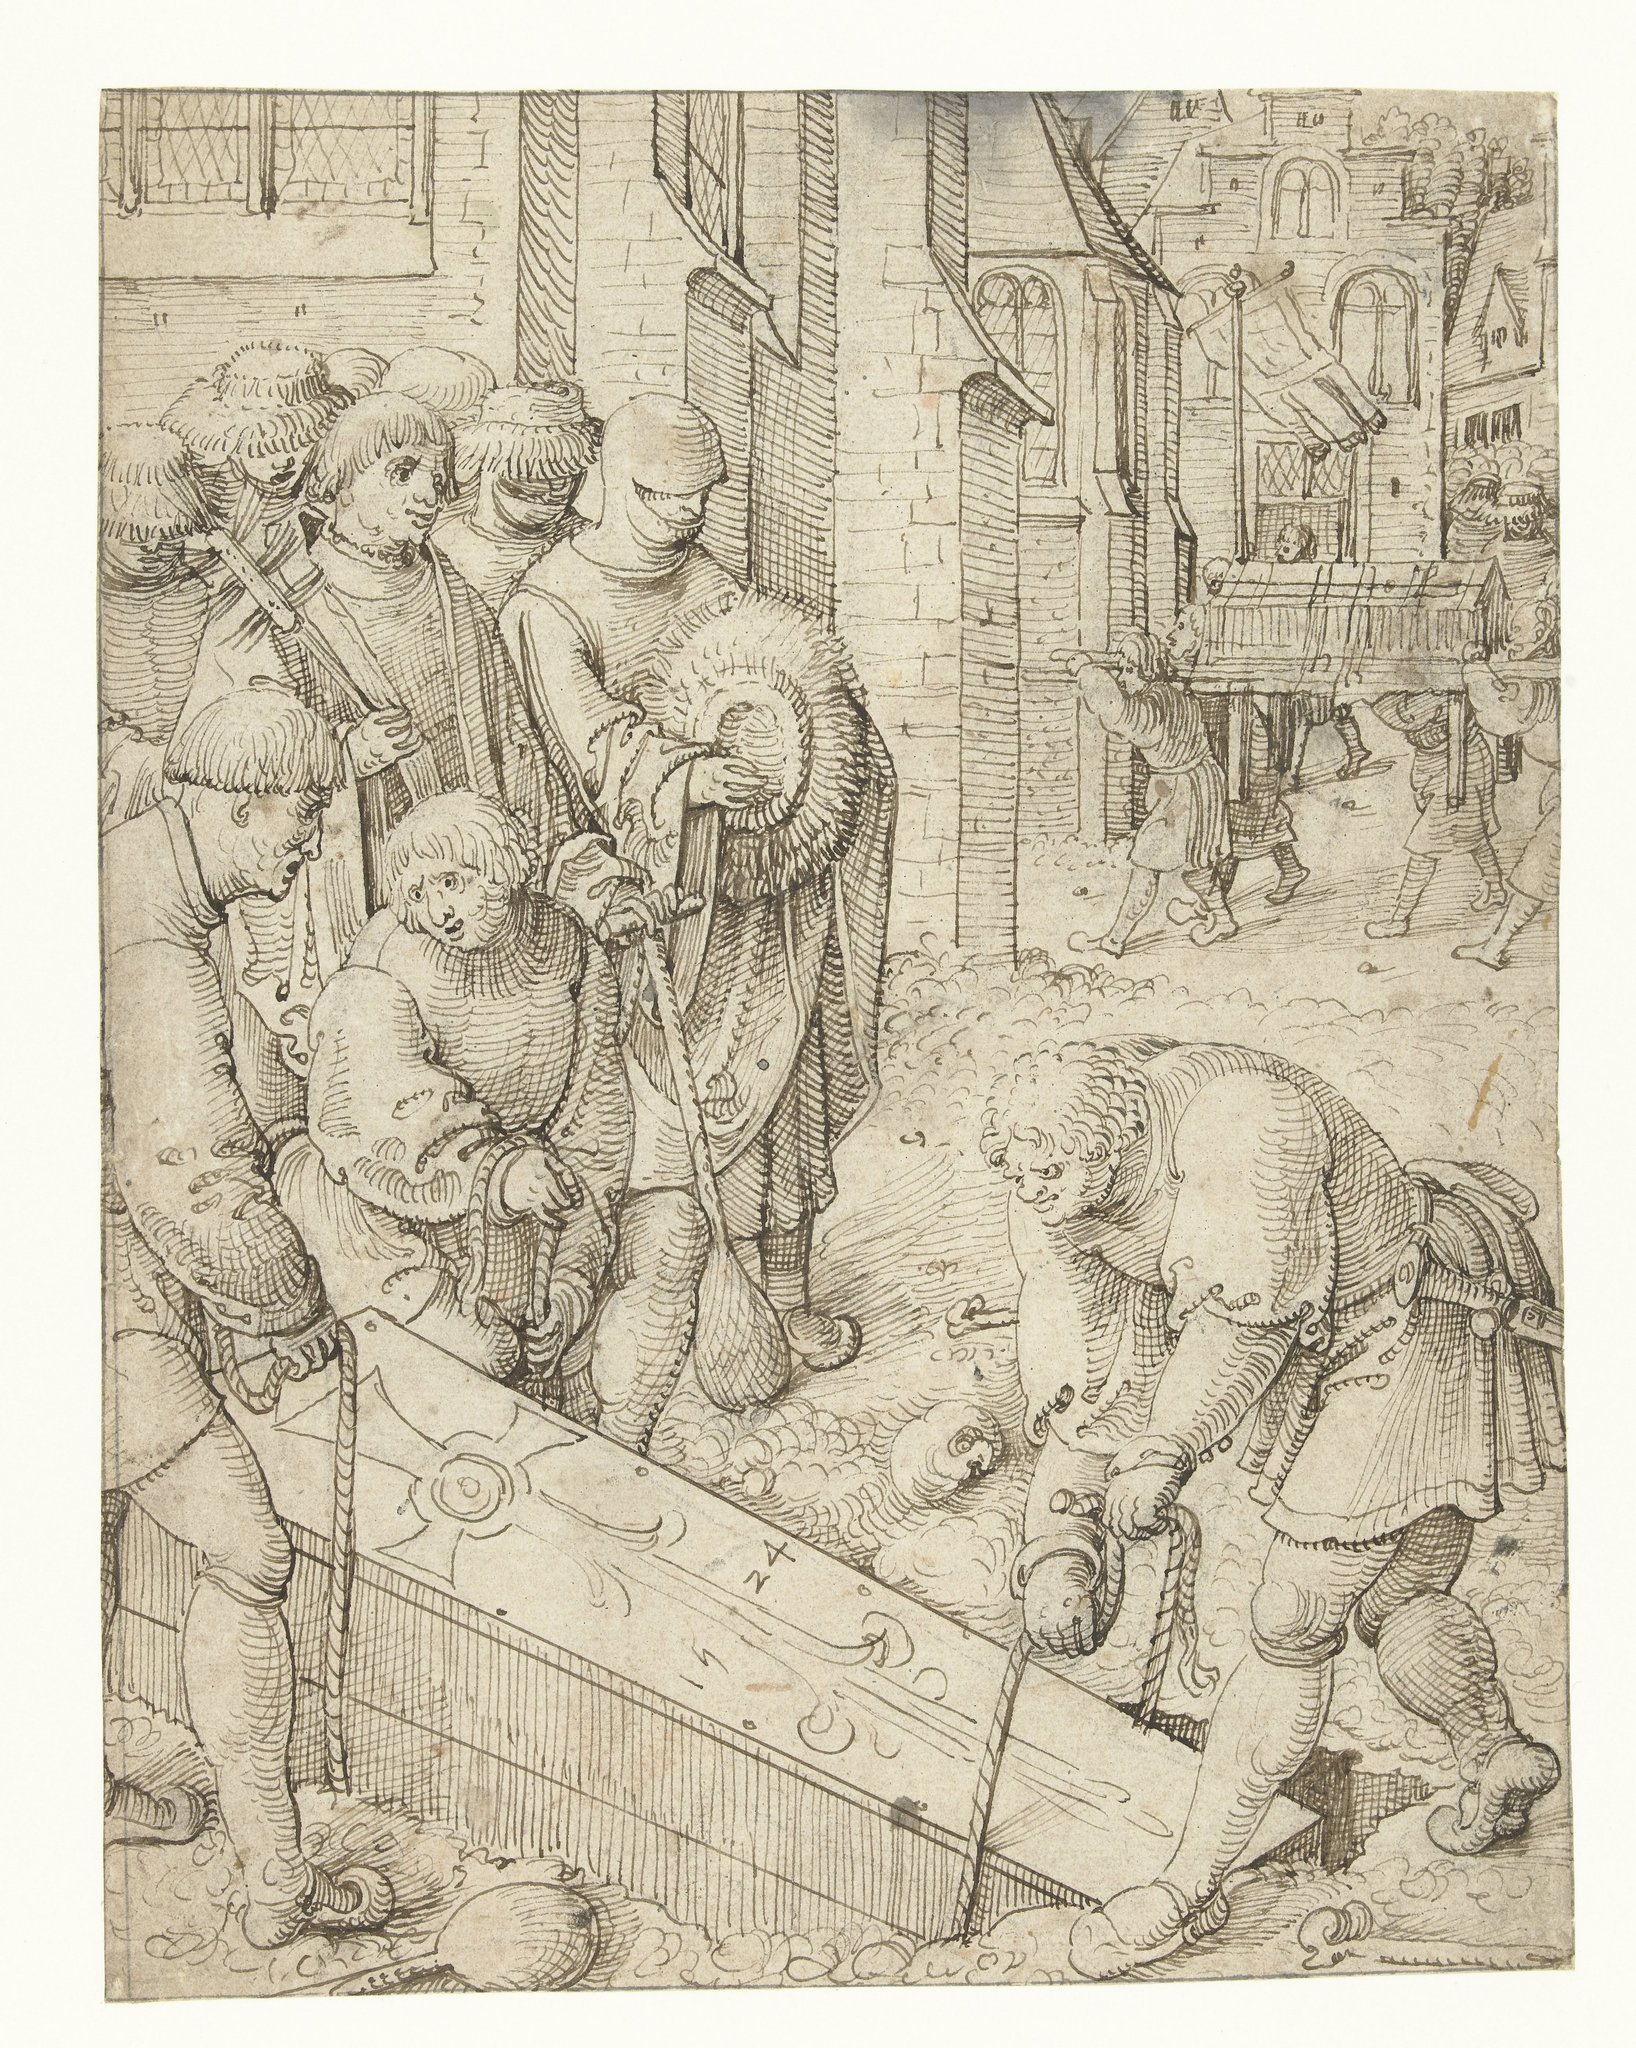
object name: drawing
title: Begraven van de doden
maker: pieter cornelisz. genaamd kunst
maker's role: draughtsman, painter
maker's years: 1480-1561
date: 1524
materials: ink, paper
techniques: pen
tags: burying the dead, 'mortuus sepellitur' ~ one of the (seven) acts of mercy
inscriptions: date: ‘1524’, monogram: ‘LC Cl’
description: Op de voorgrond laten drie mannen een doodskist in een graf zakken. Links een priester met aspersorium (wijwatersprenkelaar) en 'rouwenden' met breedgerande hoeden. Op de achtergrond wordt een doodskist een kerk binnengedragen.